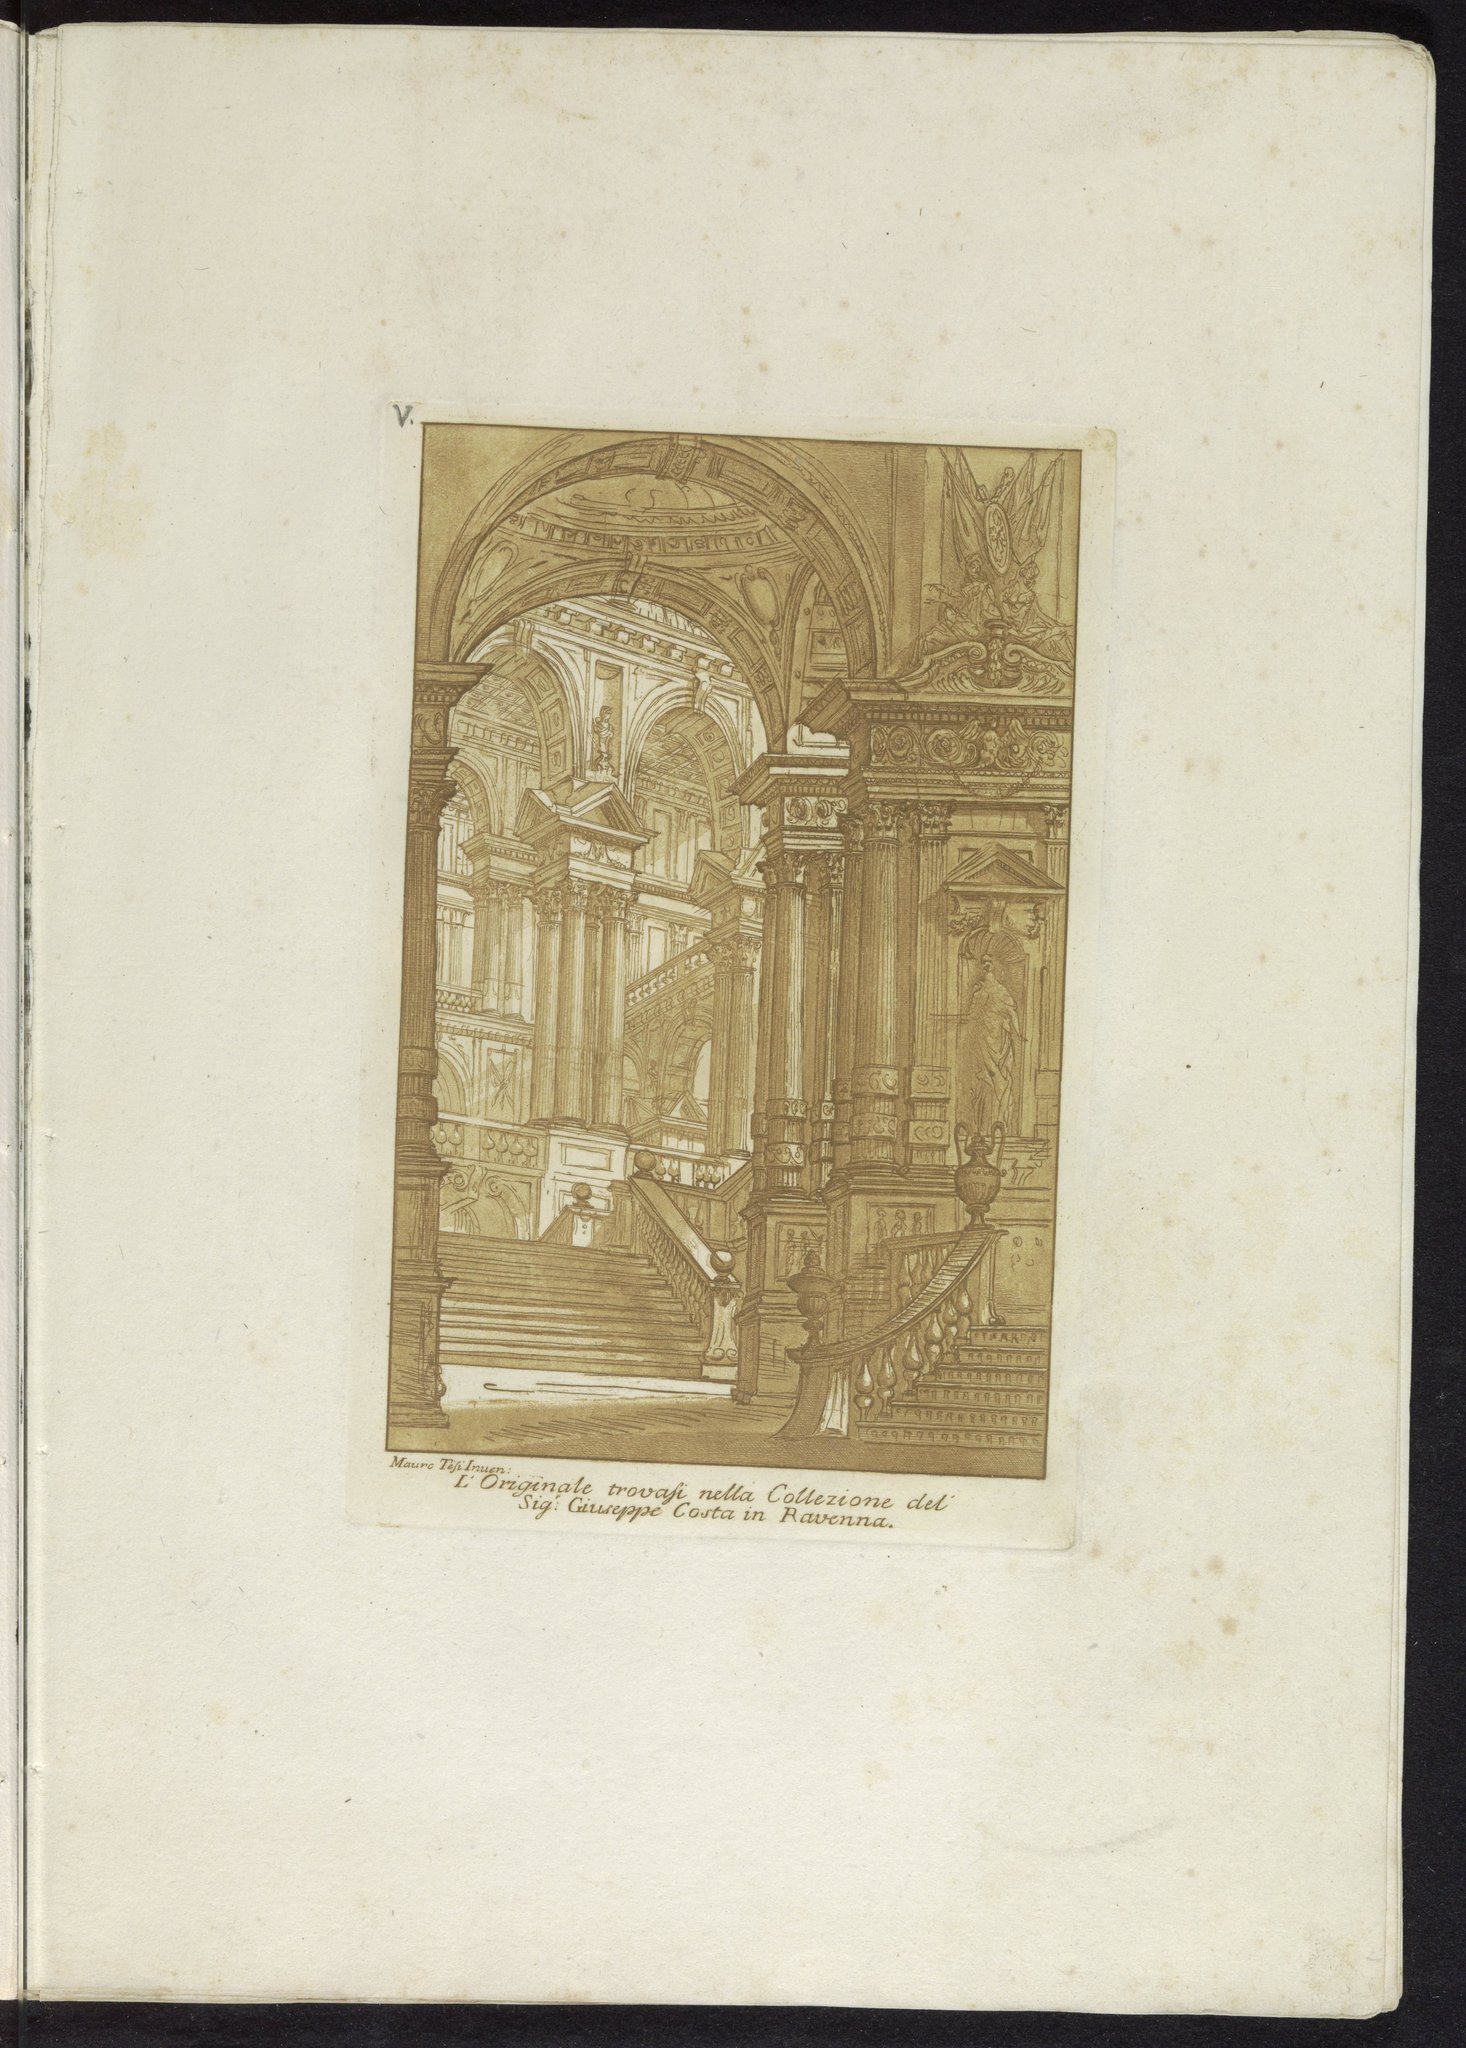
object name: print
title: Kerkinterieur met trappartijen en beeldhouwwerken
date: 1787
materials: paper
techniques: aquatint, etching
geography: bologna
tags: interior of church, piece of sculpture, reproduction of a piece of sculpture